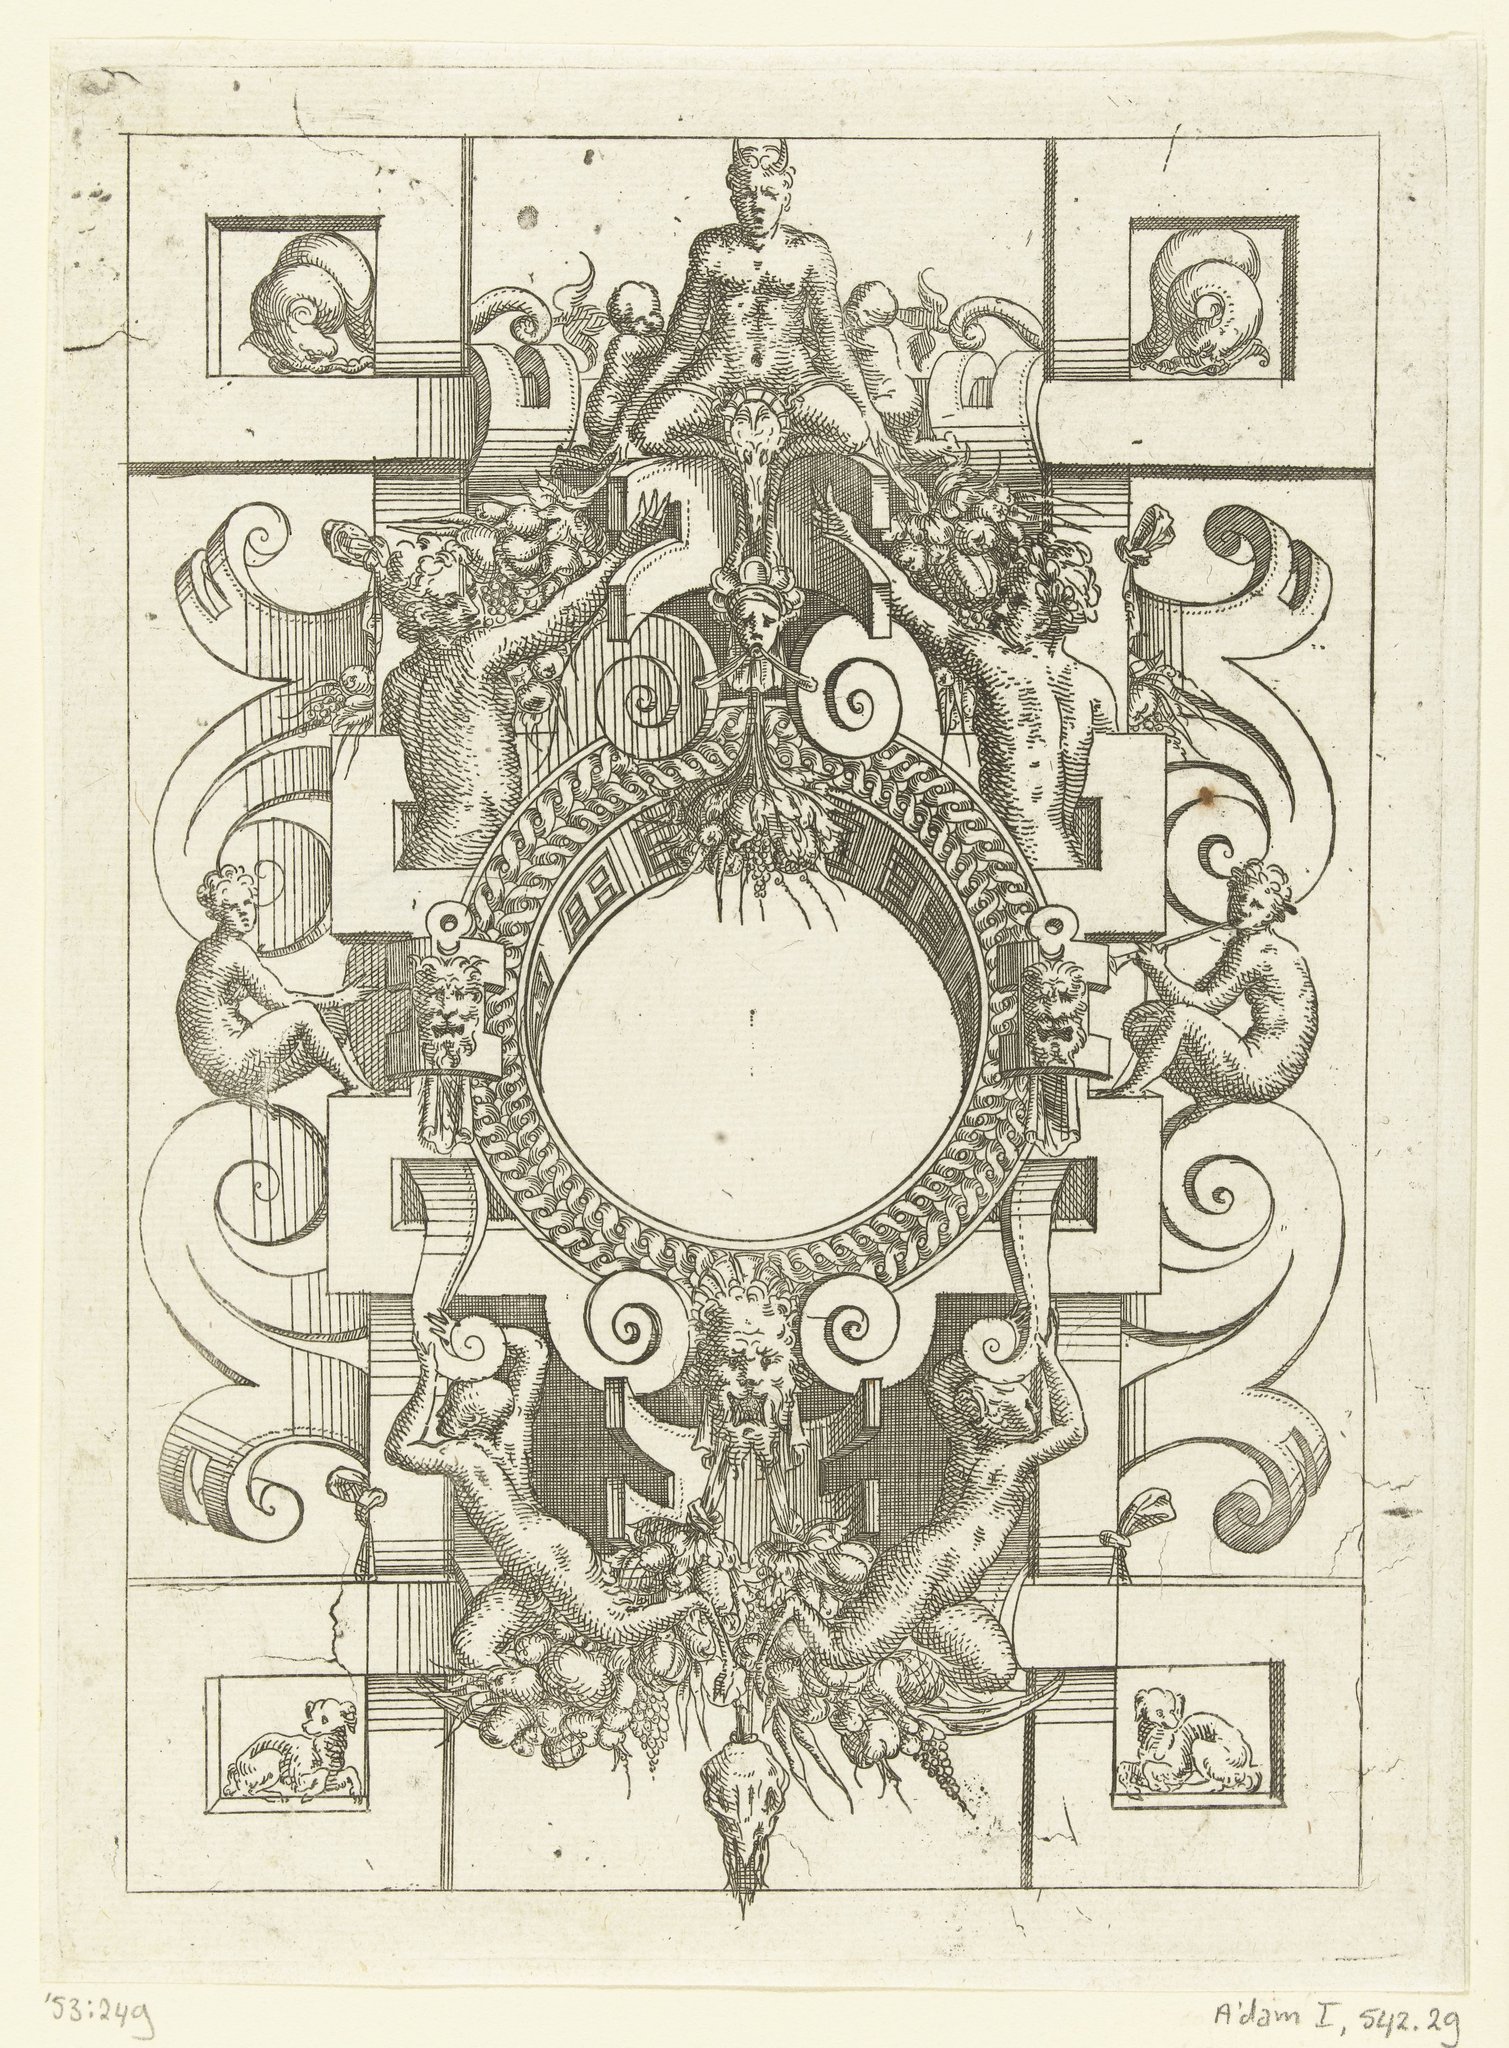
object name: ornament print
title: Kleine cartouche naar voorbeeld te Fontainebleau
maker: Anonymous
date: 1520-1584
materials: paper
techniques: etching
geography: france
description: Linksboven en rechtsboven bevindt zich een venster met een dolfijn erin. Uit serie van 32 bladen. De cartouches zijn deels ontleend aan de prenten van Antonio Fantuzzi naar de decoratie van de Galerie van François 1er door Giovanni Battista Rosso. De serie staat ook bekend onder de titel Petits cartouches de Fontainebleau.